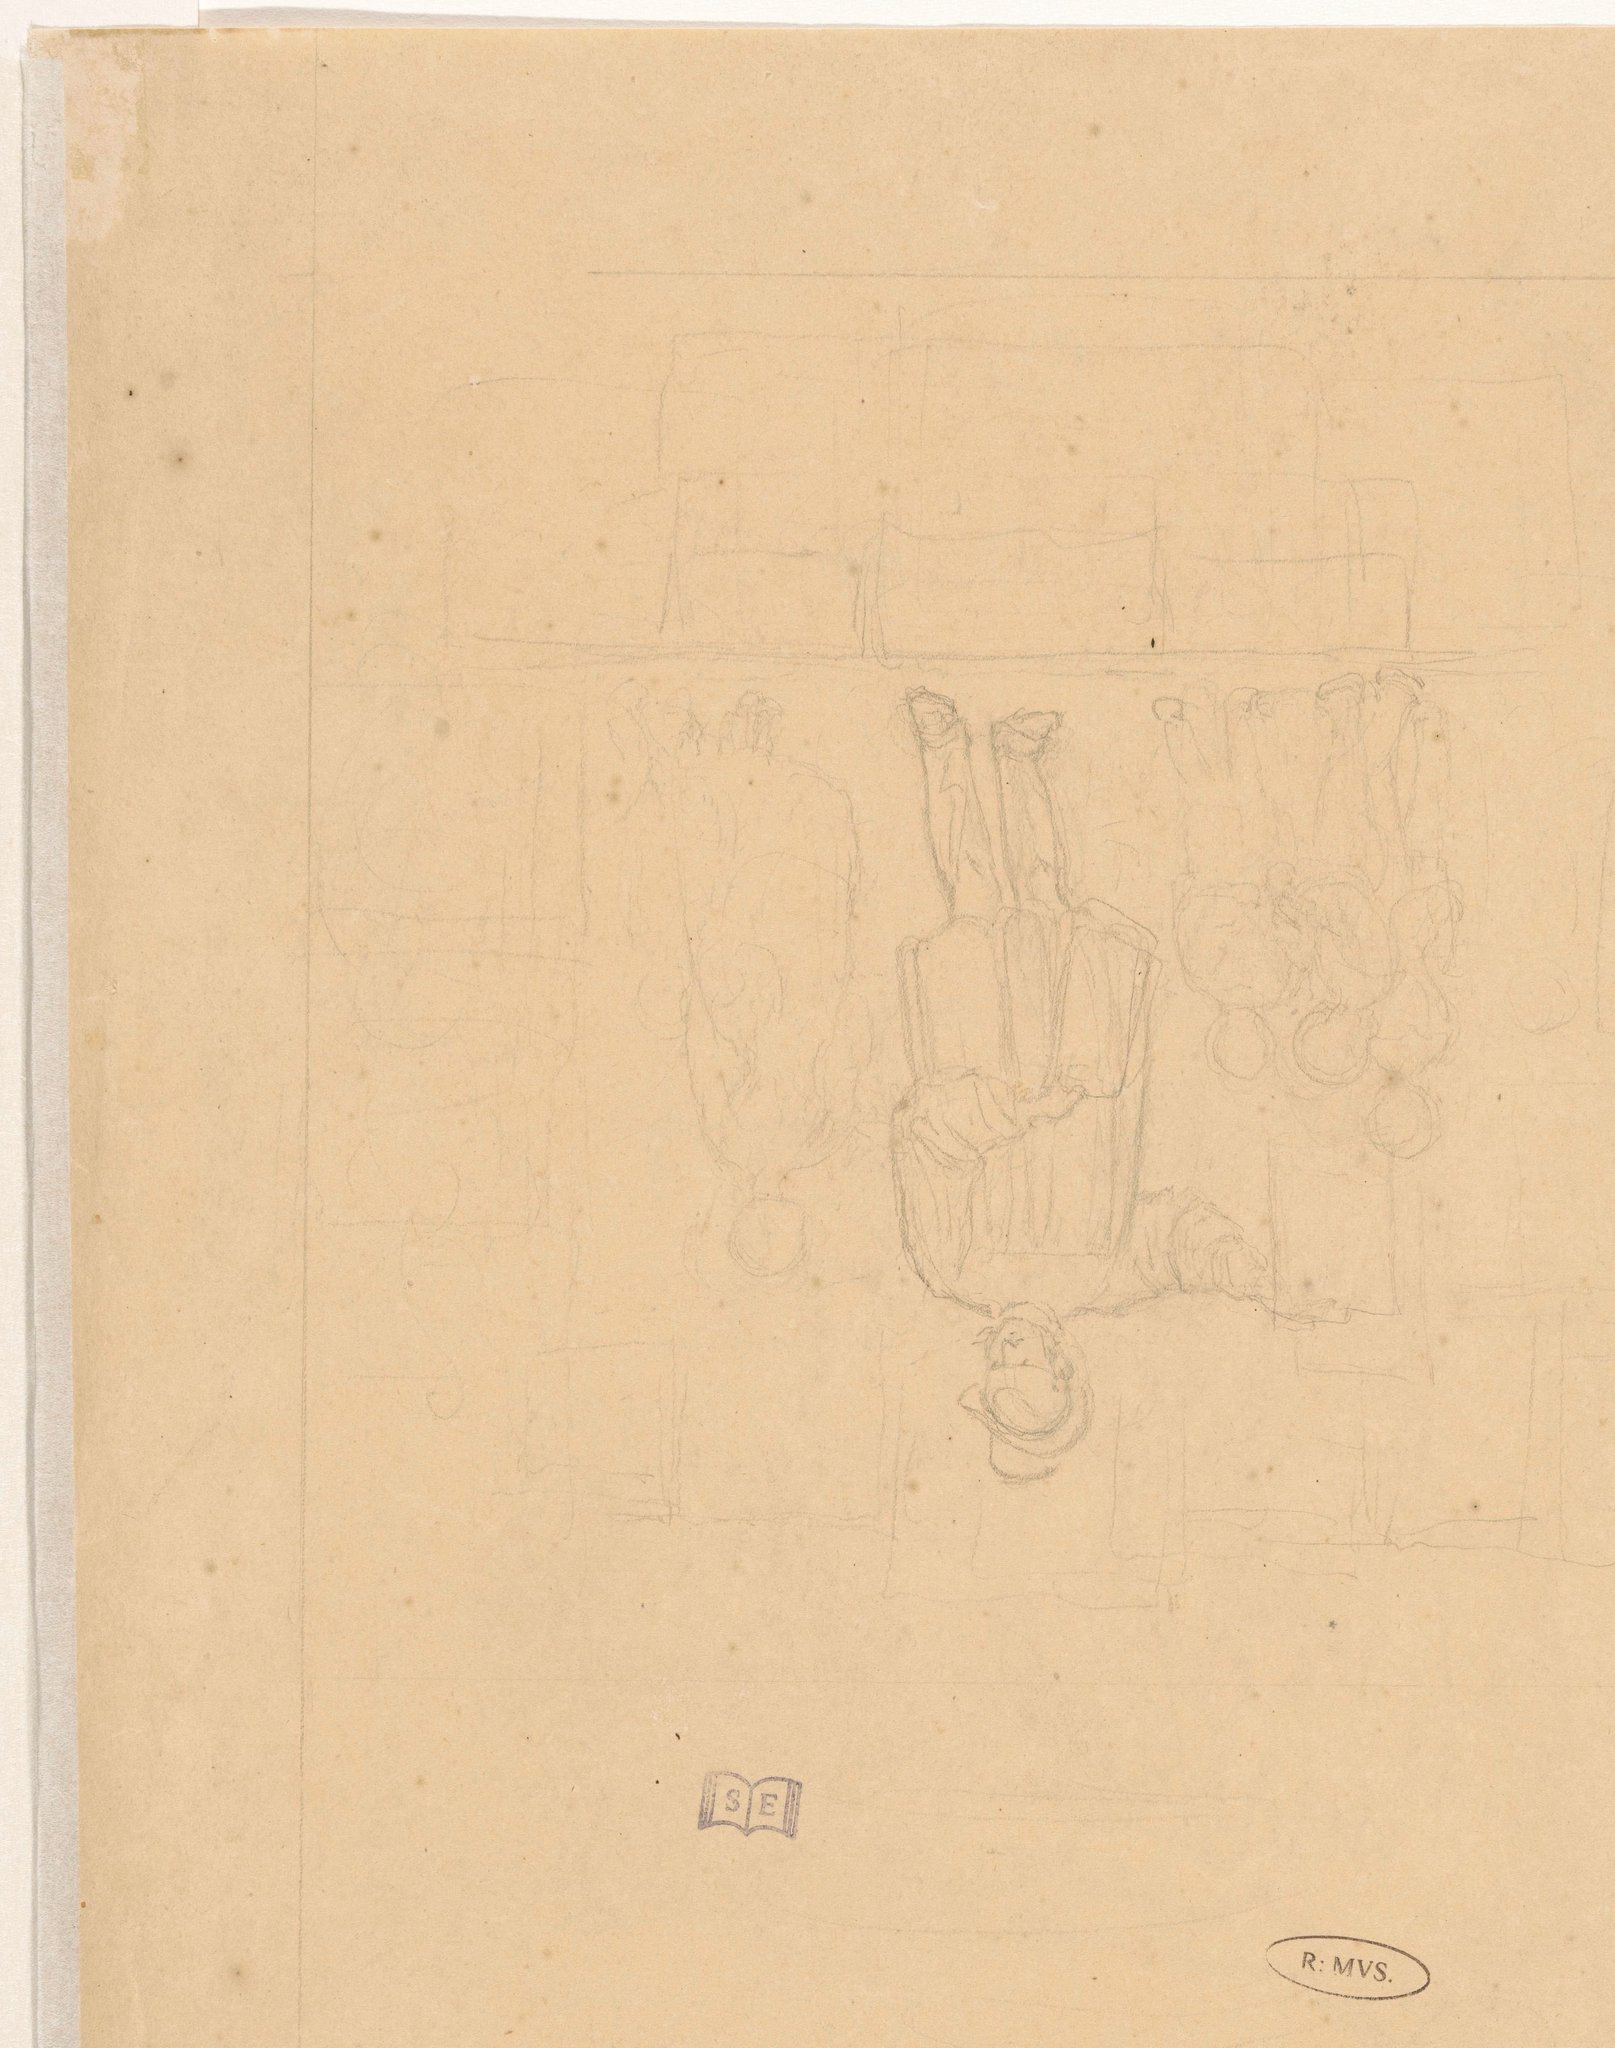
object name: design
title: Prentverkoper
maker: august ferdinand hopfgarten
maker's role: draughtsman, painter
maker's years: 1807-1896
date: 1817-1896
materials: paper, pencil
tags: print, e.g.: engraving, etching, lithograph, street-trader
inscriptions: annotation: ‘Nachl. Hofgarten No. 71’, collector's mark: Lugt 2228, annotation: ‘ontwerp voor het titelblad voor een kinderboek door de doorl. portret- en genre schilder August Ferdinand Hofgarten 1807-1896’, collector's mark: Lugt 4779